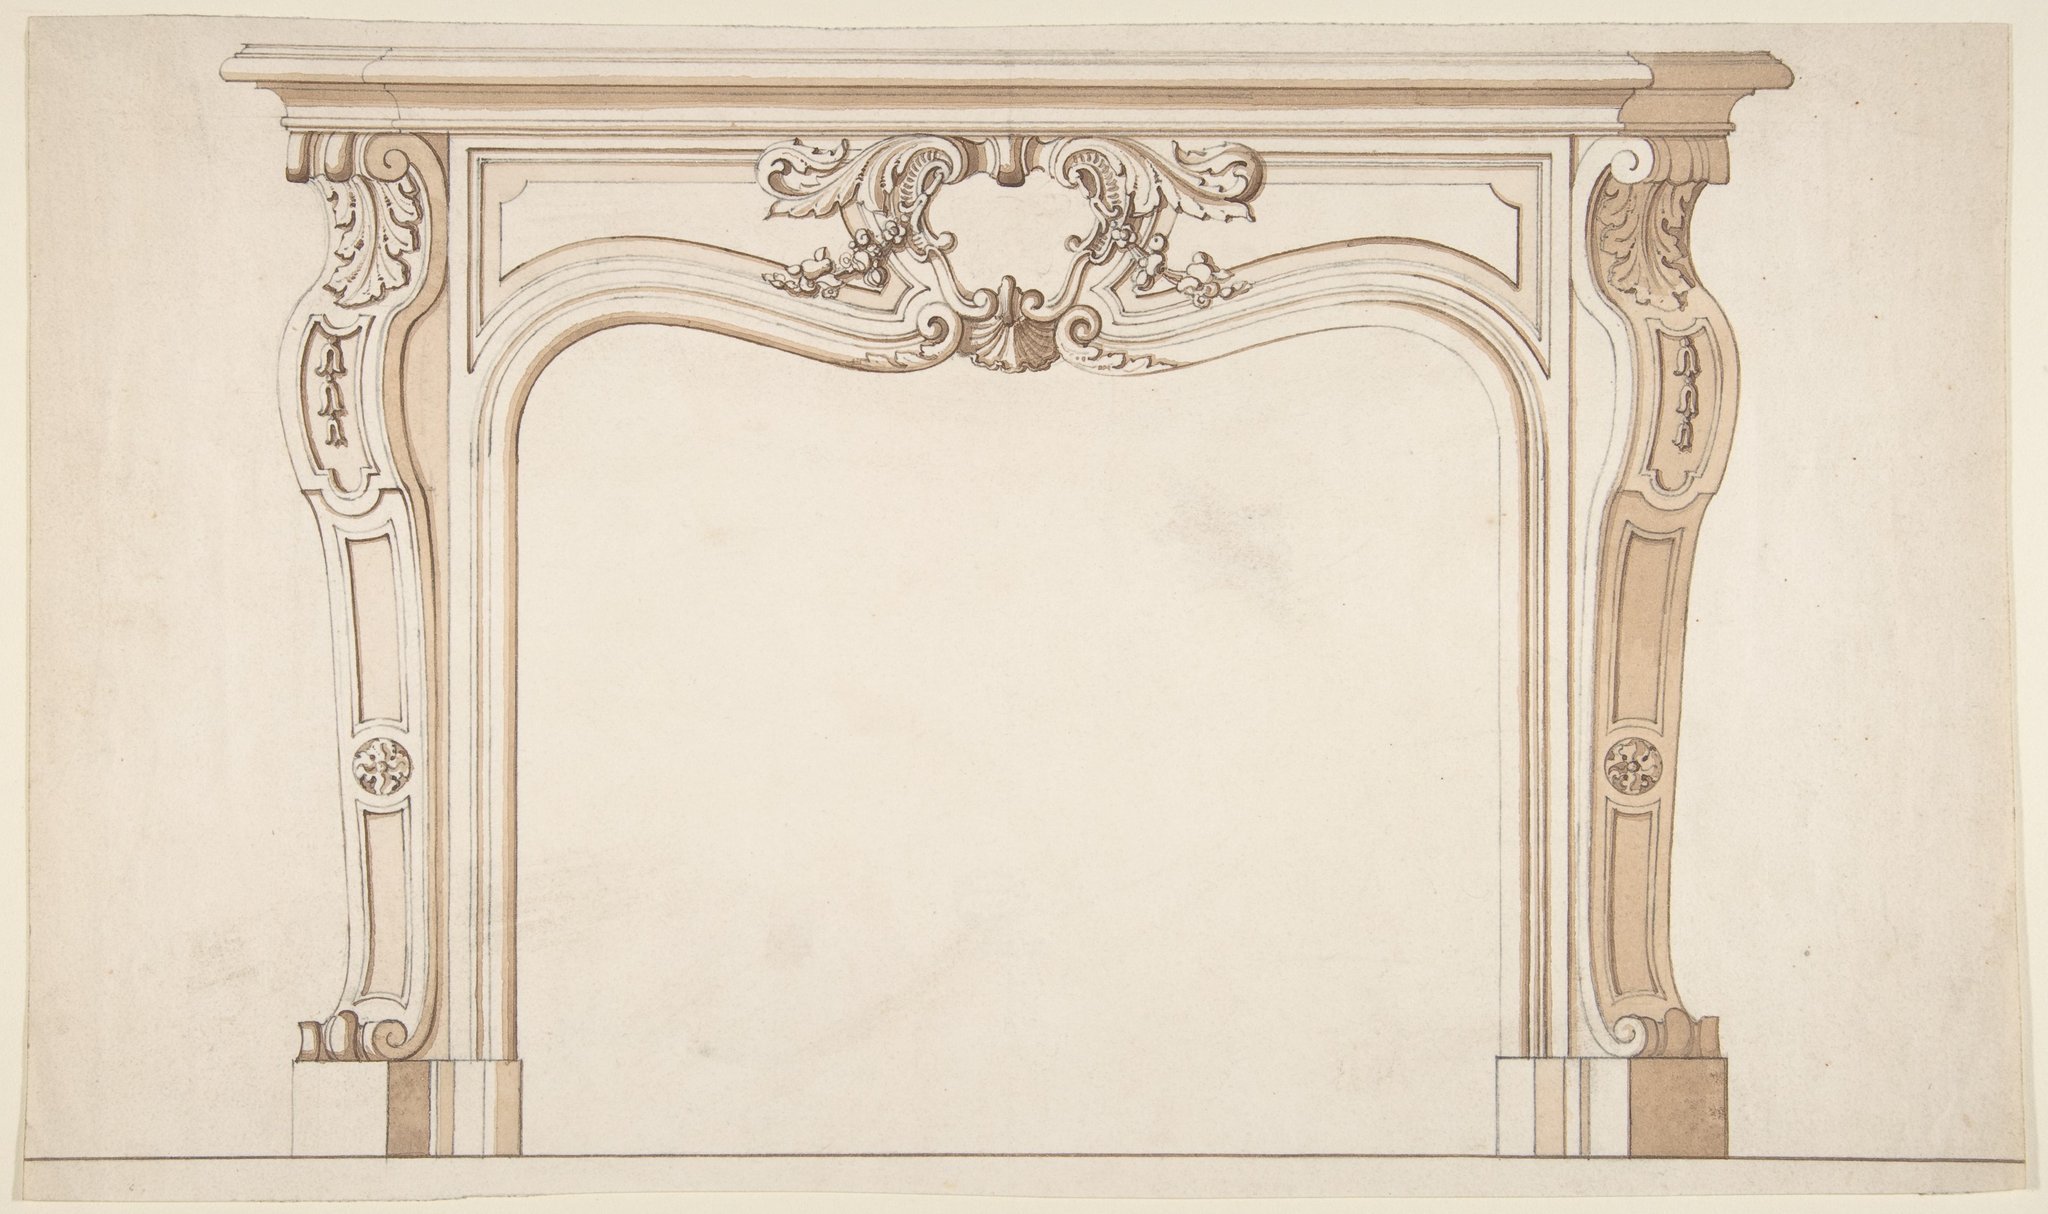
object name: drawing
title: Drawing for a Chimney-piece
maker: delorme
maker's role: artist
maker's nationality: french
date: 1850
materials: graphite, ink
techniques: brush, pen, wash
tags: architecture